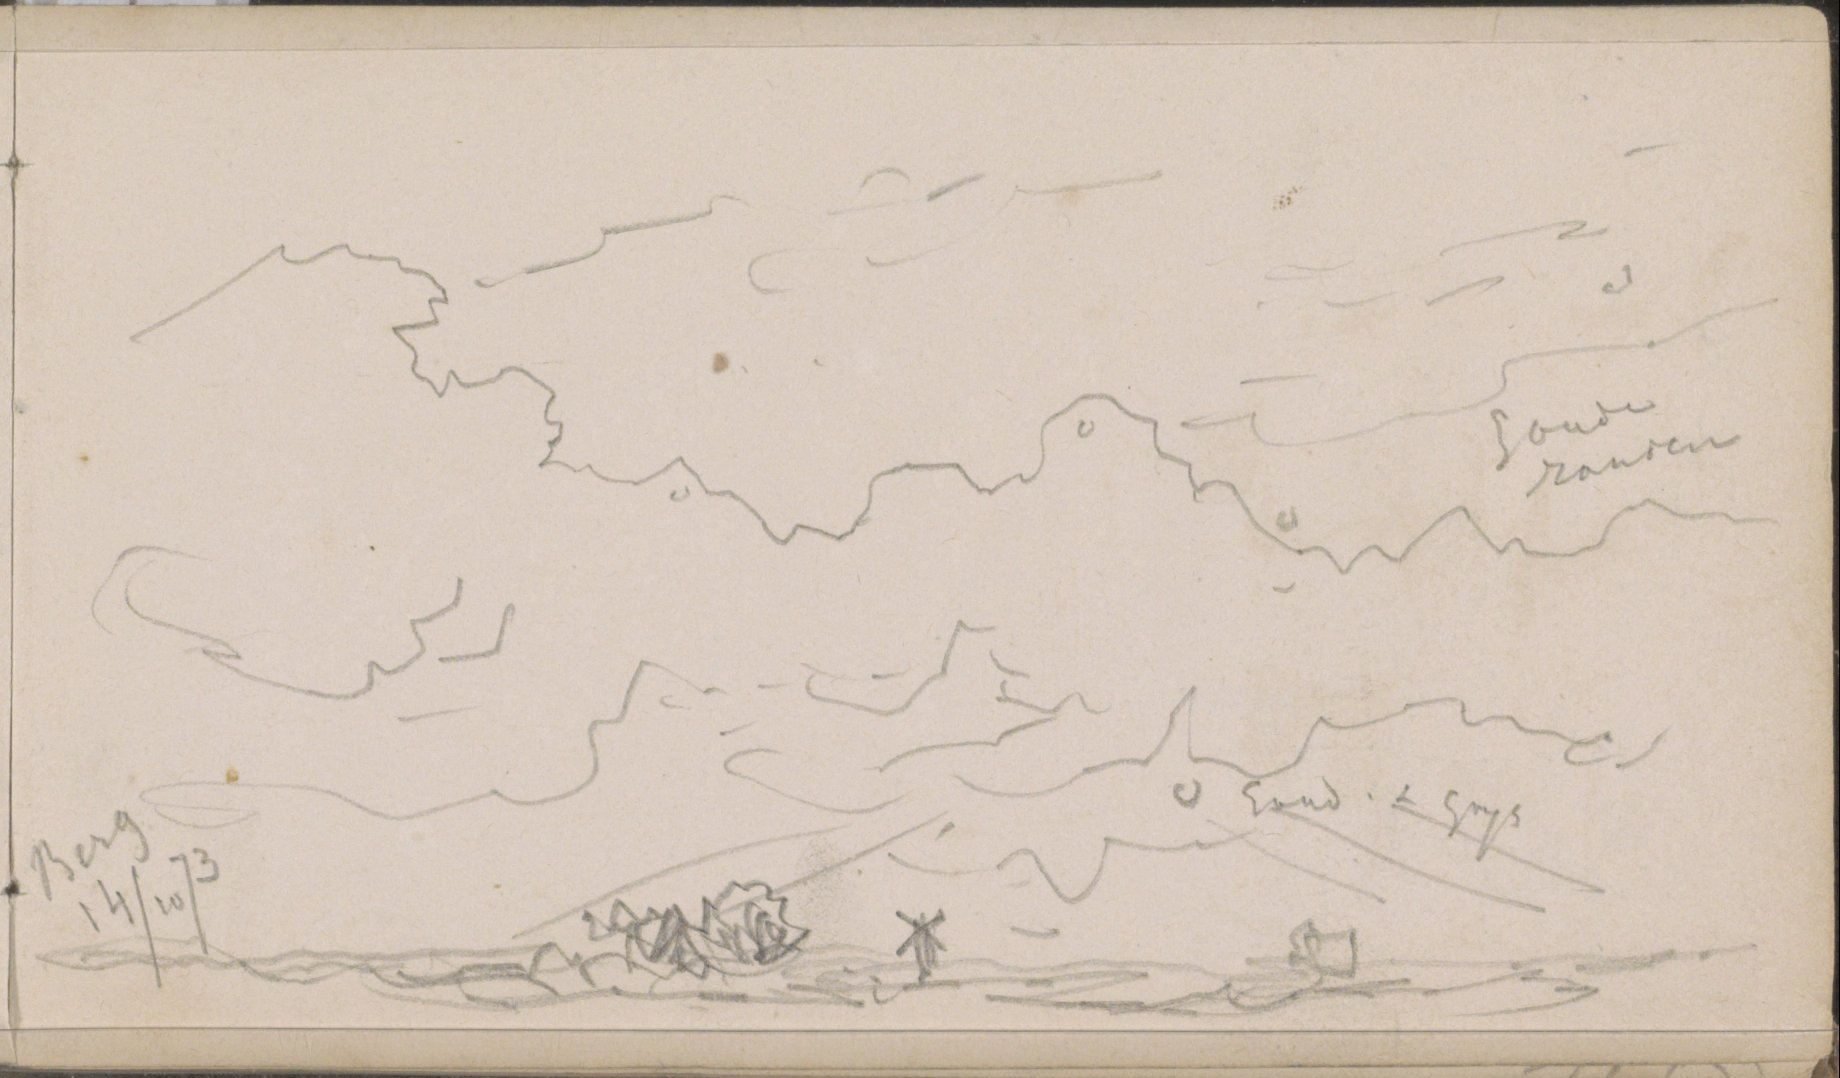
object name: sketchbook leaf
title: Wolkenlucht boven een vlak landschap met een molen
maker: johannes tavenraat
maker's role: draughtsman, painter, print maker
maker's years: 1809-1881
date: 1810-1873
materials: paper, pencil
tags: clouds, windmill in landscape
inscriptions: date and inscription: ‘Berg/ 14/10 73’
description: Blad 4 recto uit een schetsboek met 46 bladen.